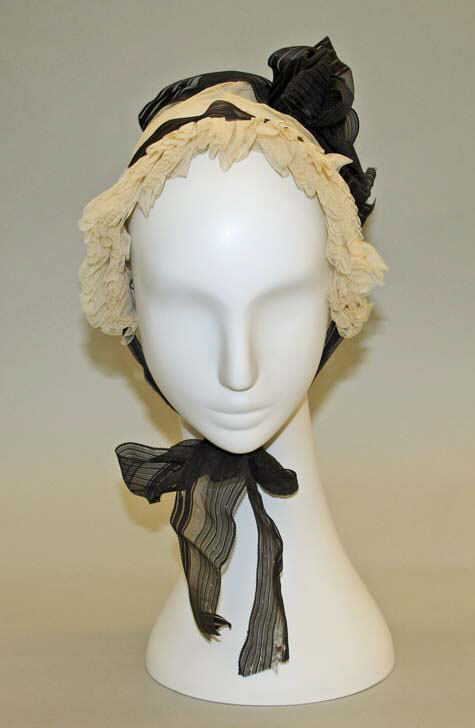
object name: cap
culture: american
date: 1860